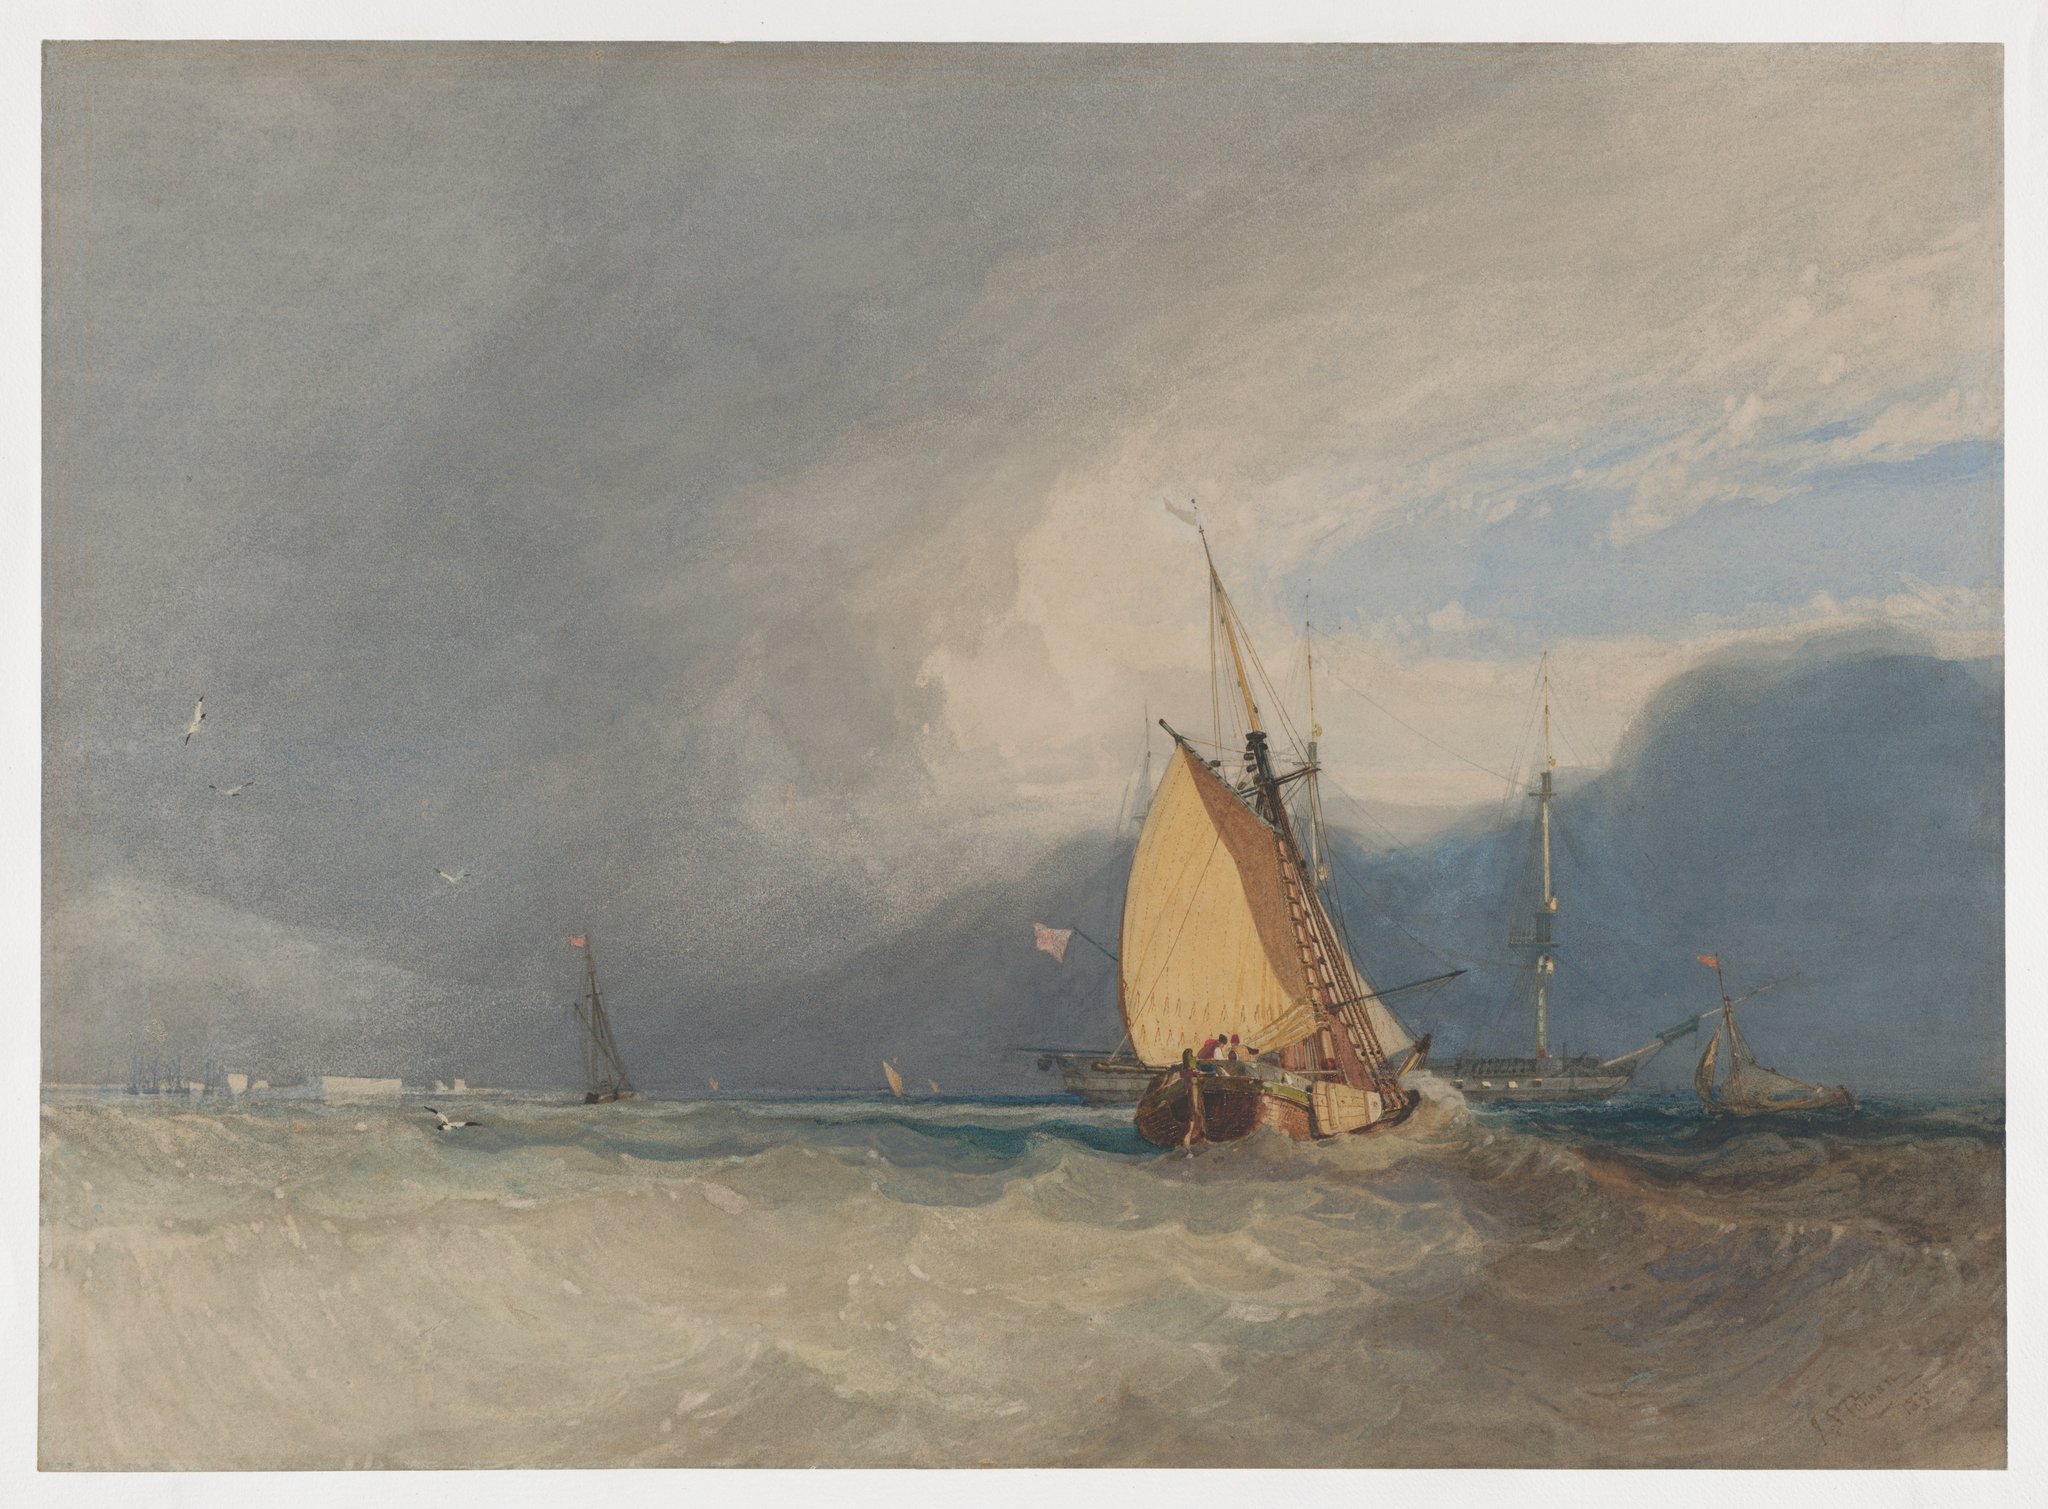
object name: drawing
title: Boats off the coast, storm approaching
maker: john sell cotman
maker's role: artist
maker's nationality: british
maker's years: 1782-1842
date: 1830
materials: gouache, graphite, gum arabic, watercolor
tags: seascapes,waves,storms,boats